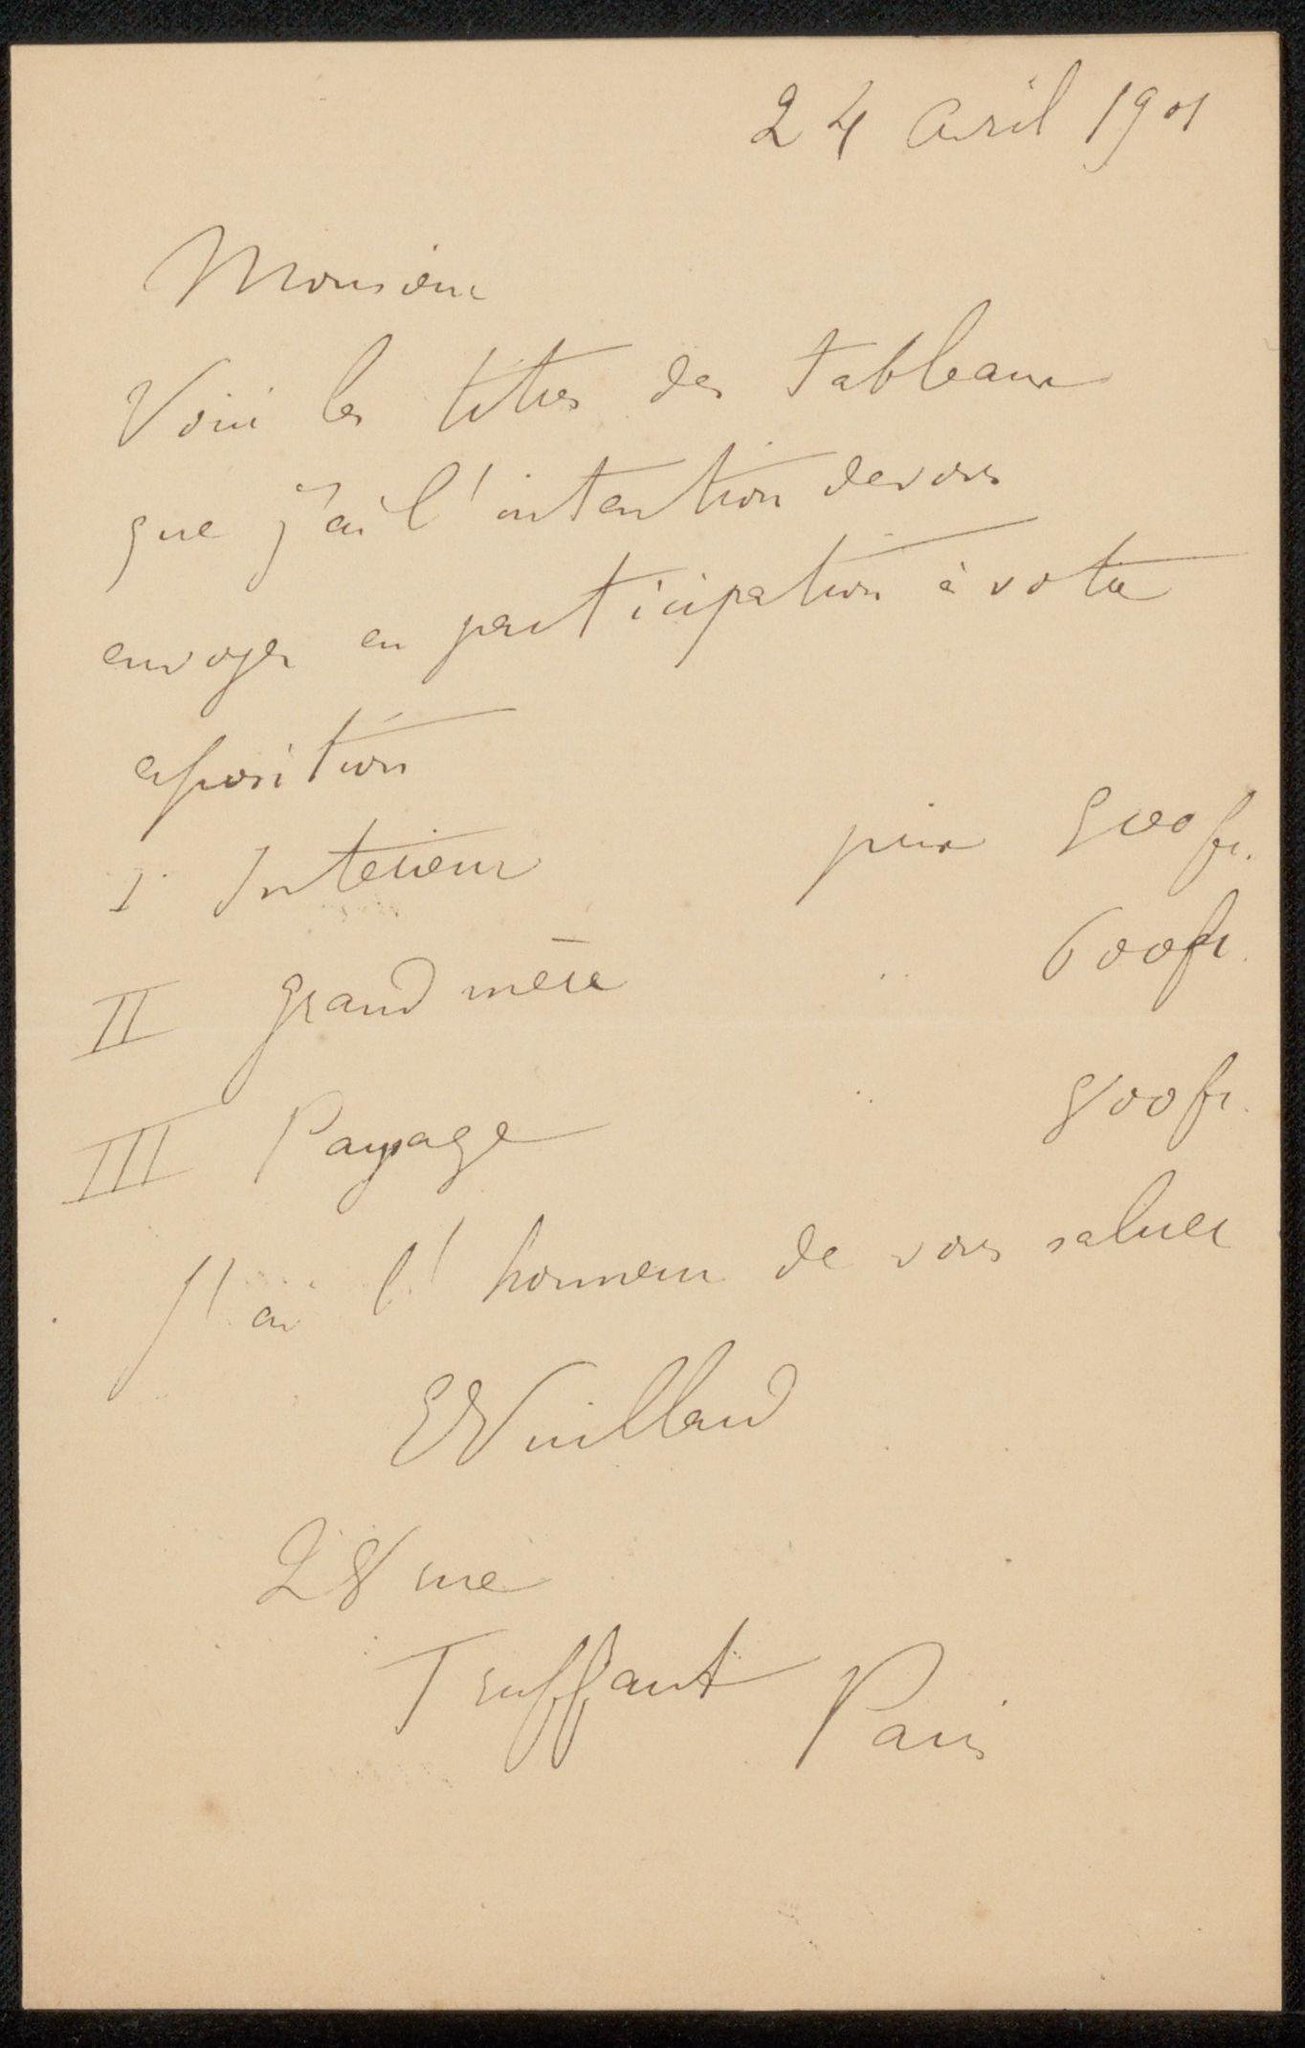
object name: letter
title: Brief aan Philip Zilcken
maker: édouard vuillard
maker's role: draughtsman, print maker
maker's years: 1868-1940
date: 1901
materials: ink, paper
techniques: pen, writing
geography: paris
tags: the hague, painter, philip zilcken, painting (including book-illumination, miniature-painting), exhibition ~ art, money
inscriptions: watermark, collector's mark: ‘RPK’